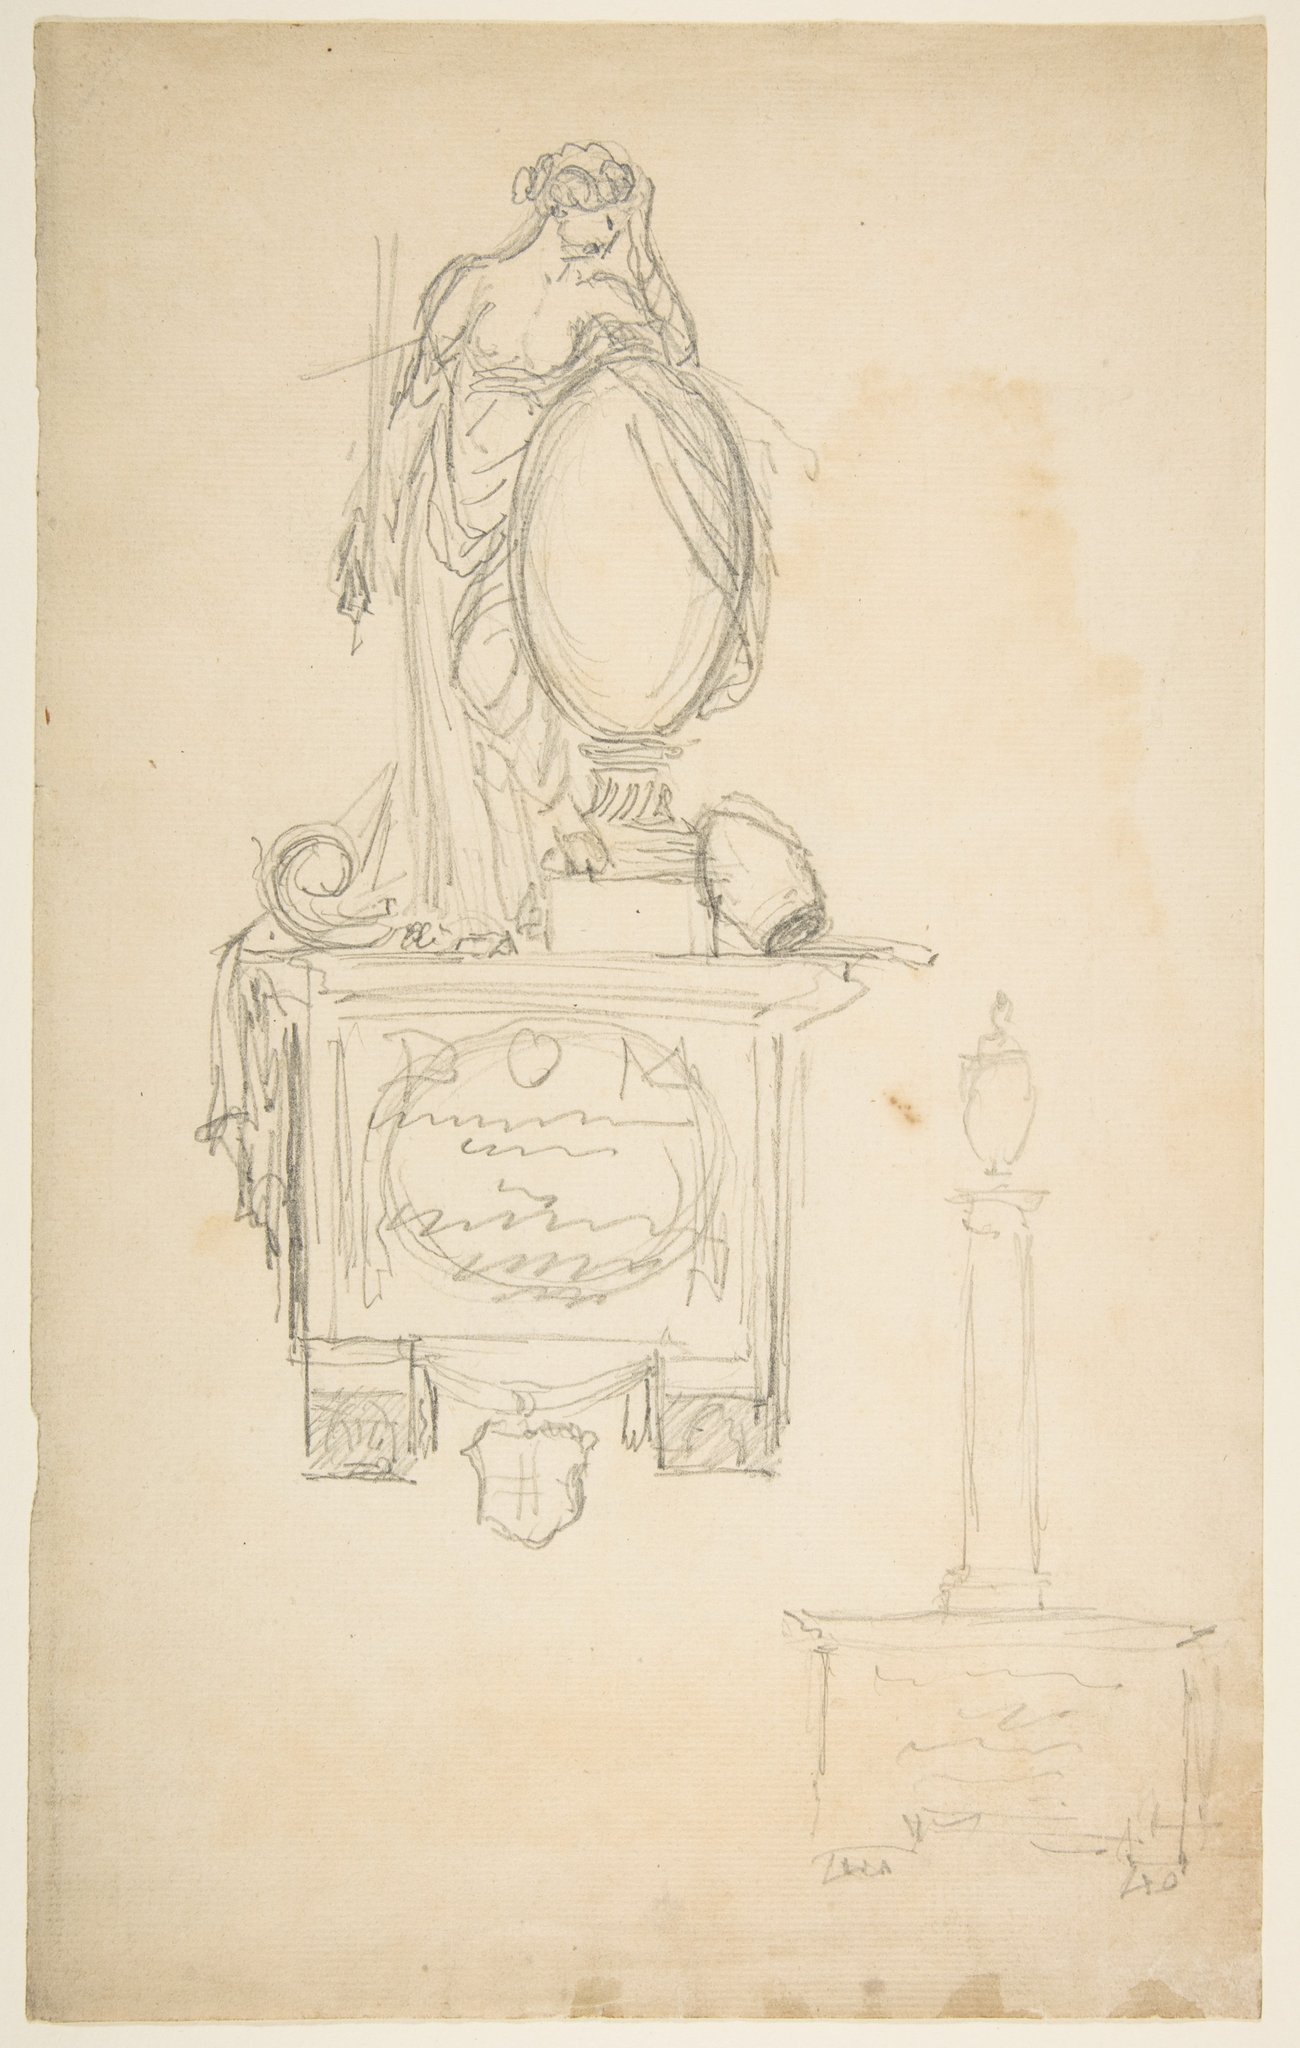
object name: drawing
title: Design for a Sculpture or Monument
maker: anonymous, french, 19th century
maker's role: artist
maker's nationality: french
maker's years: 1800-1900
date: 1801-1900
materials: graphite, paper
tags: sculpture,women